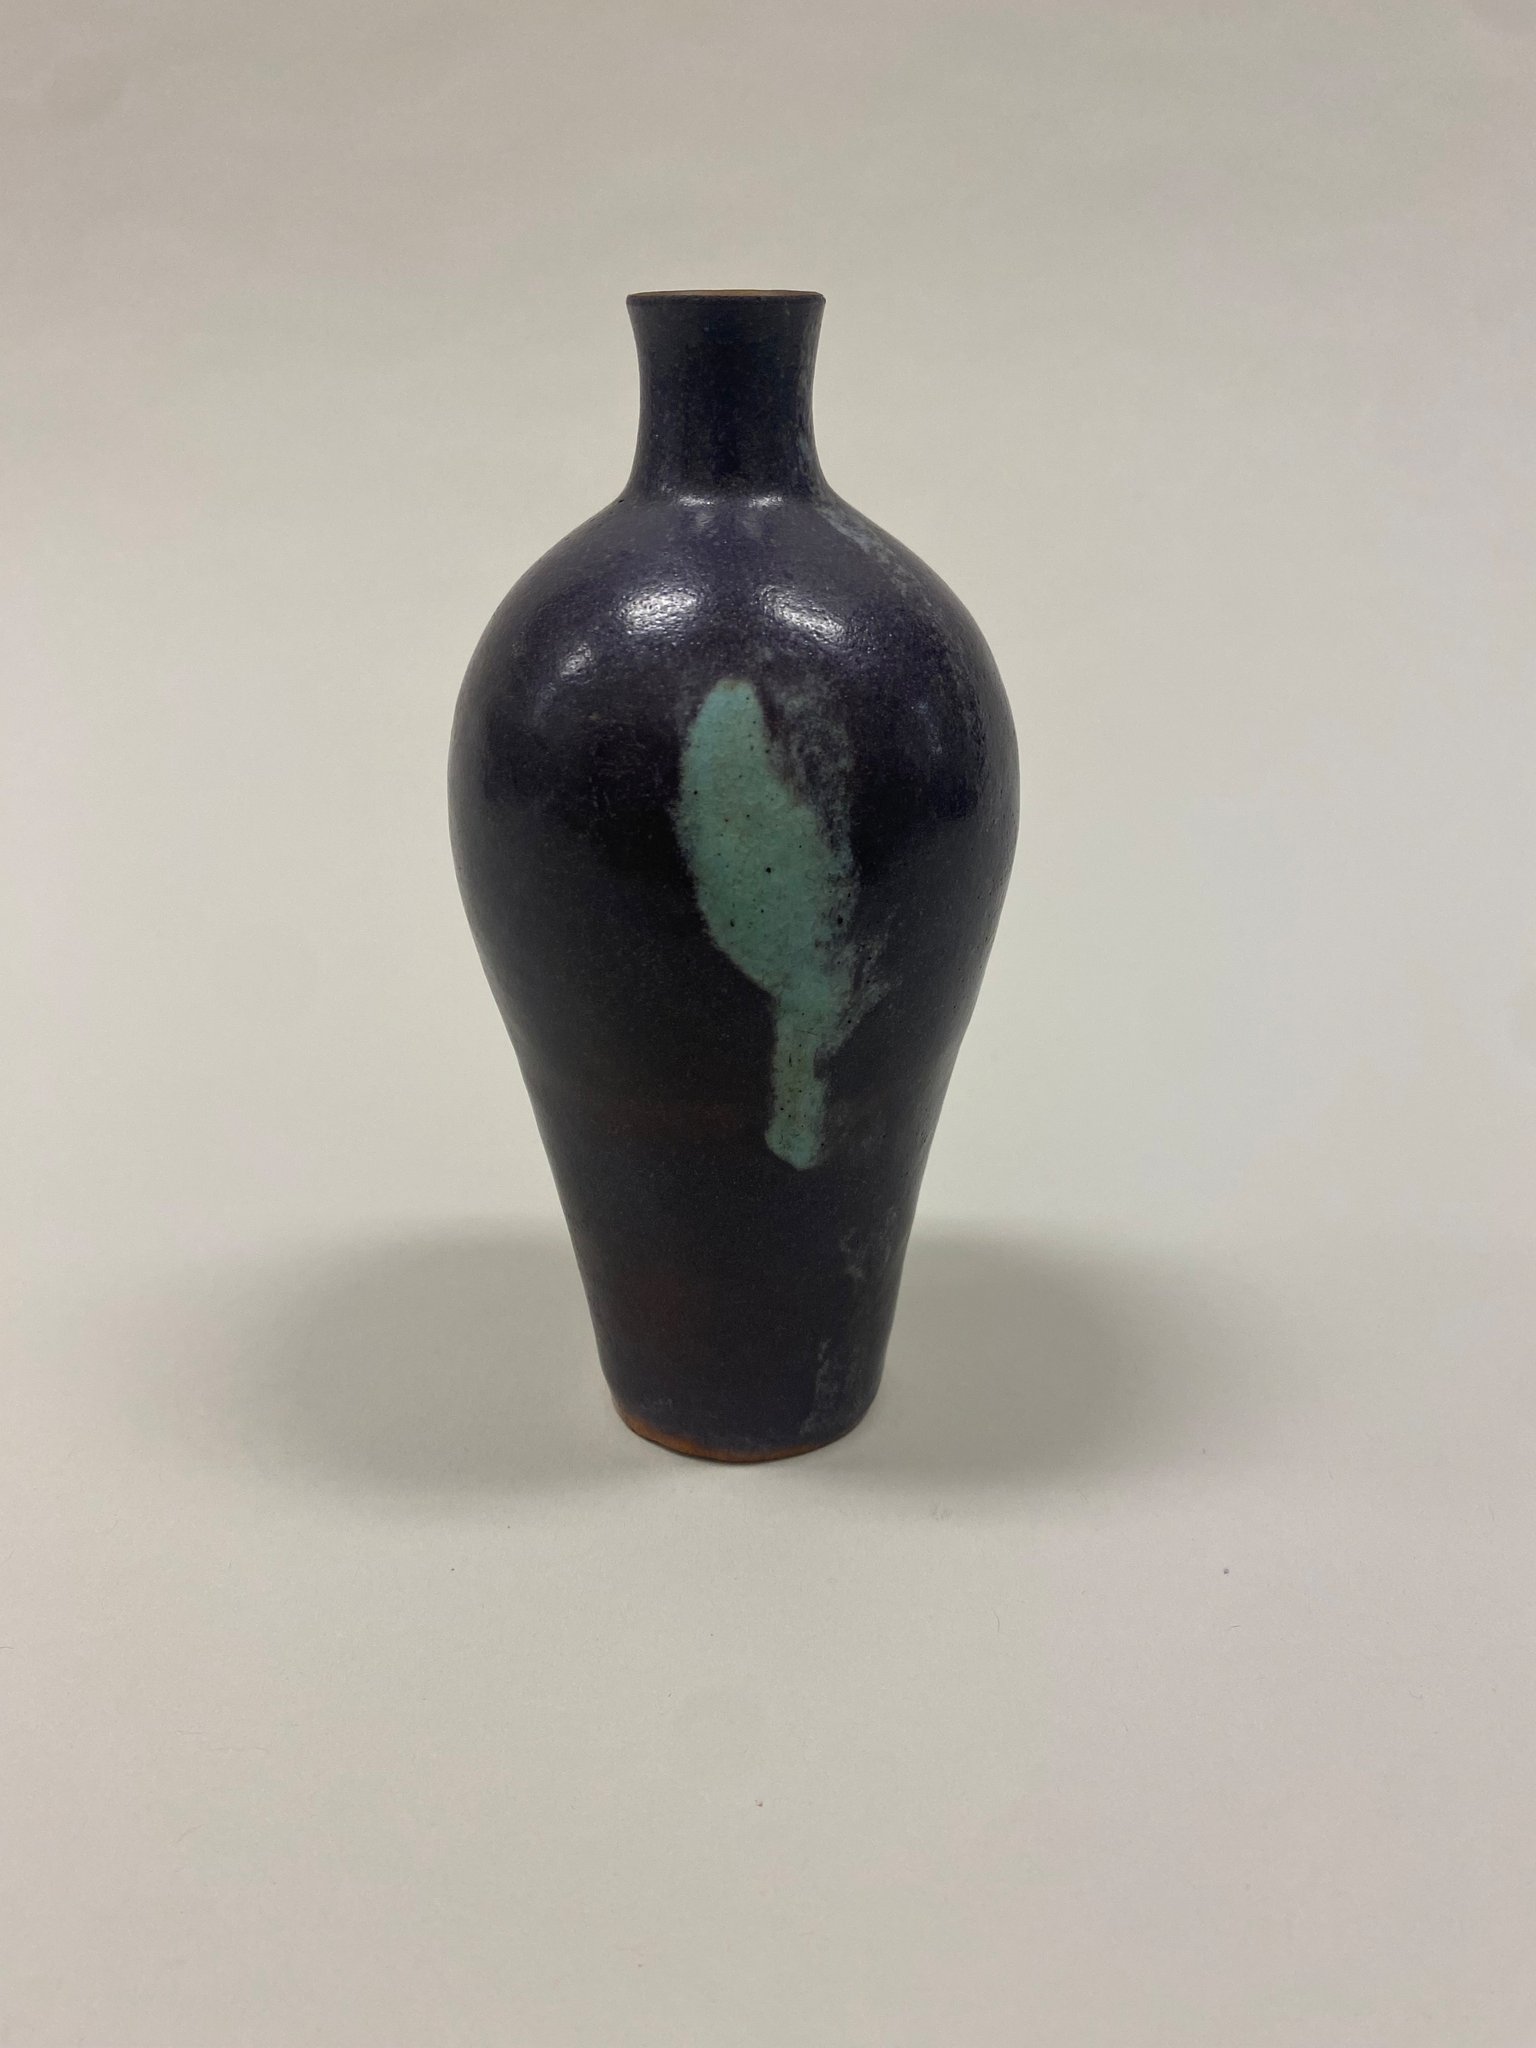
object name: vase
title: Meiping vase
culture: chinese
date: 1801-1900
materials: glaze, stoneware